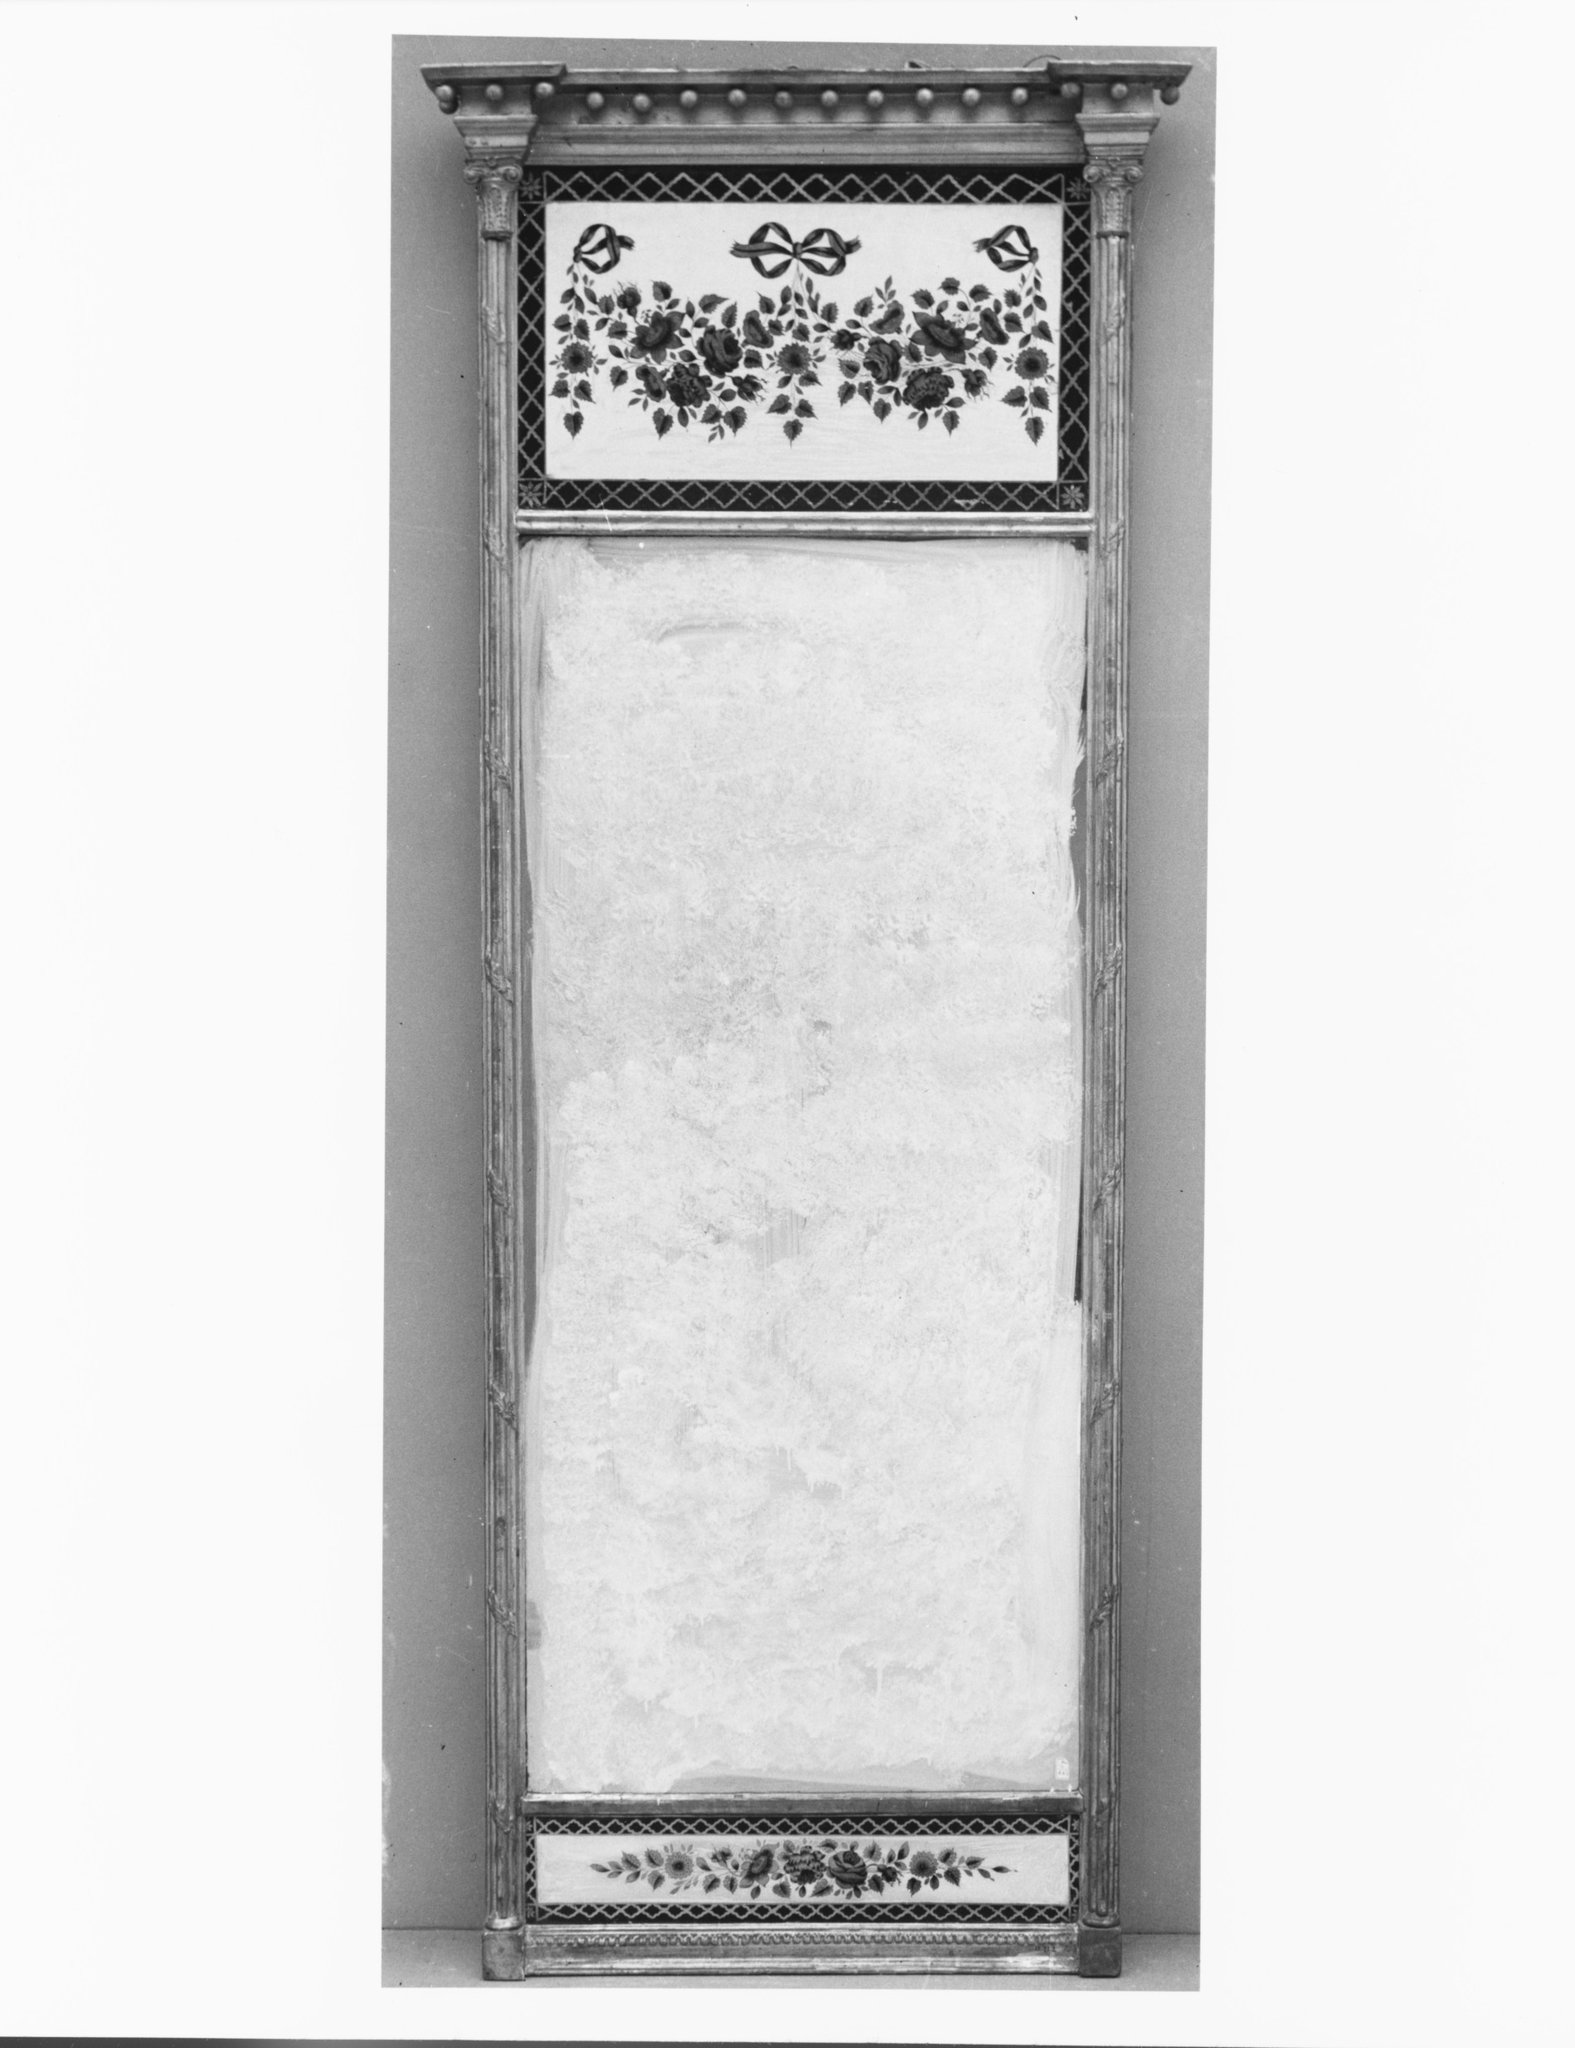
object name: pier glass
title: Pier Looking Glass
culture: american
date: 1795-1810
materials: gesso, gilt, wood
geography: united states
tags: flowers